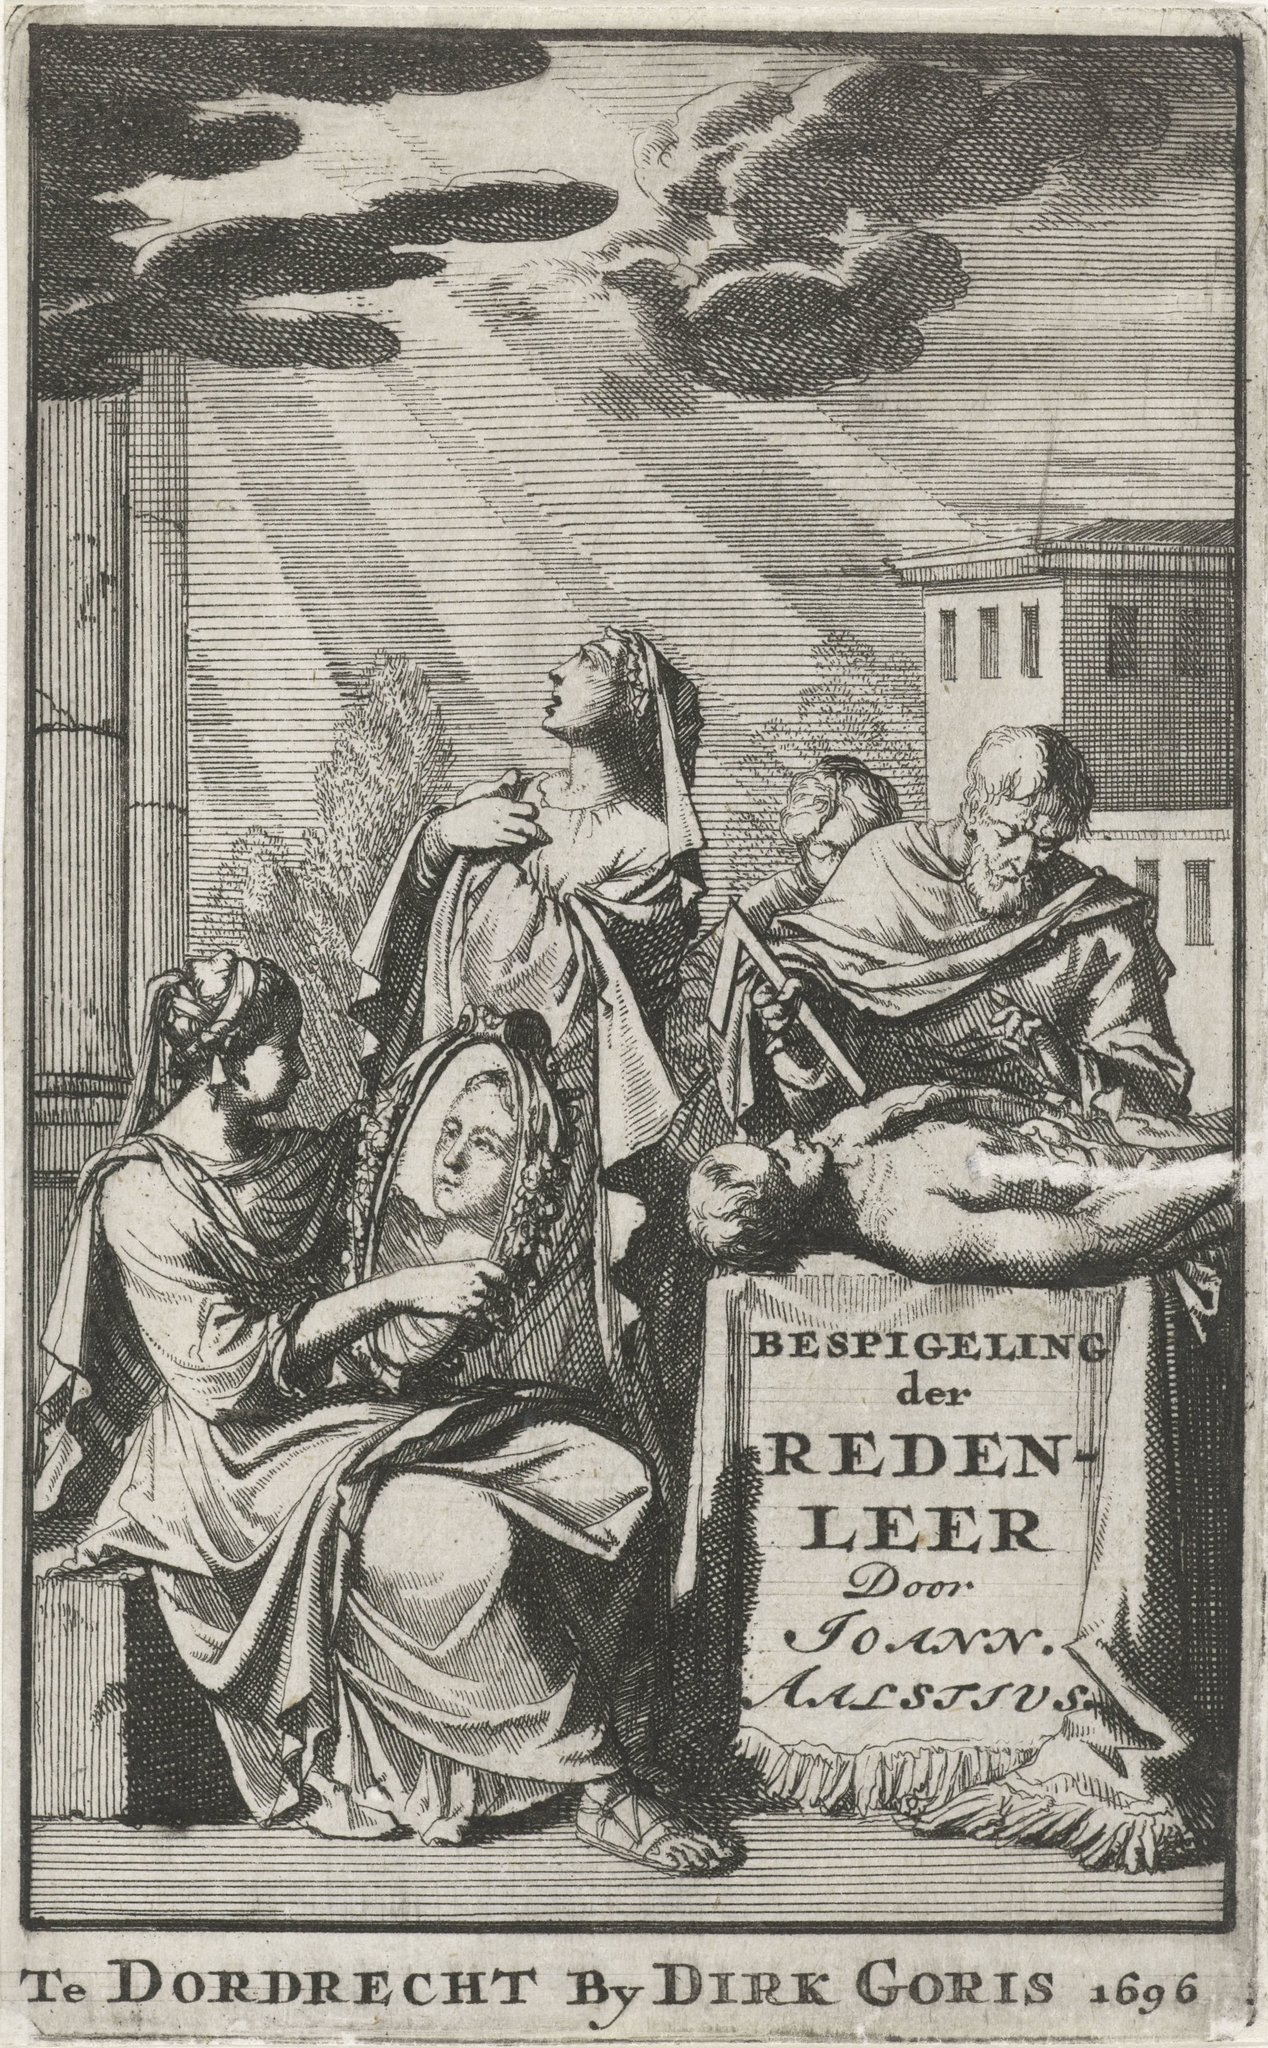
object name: print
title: Zittende vrouw bekijkt zichzelf in een spiegel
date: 1696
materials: paper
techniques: etching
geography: dordrecht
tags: physiology and anatomy (+ scholar, scientist (at work)), looking in the mirror; (possibly: contemplation of own beauty - aa - (for) women), light shining out of the heavens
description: Een zittende vrouw bekijkt zichzelf in een spiegel. Naast haar bestudeert een man de ingewanden van een overleden figuur. Hierachter wordt een vrouw beschenen door bundels hemellicht.